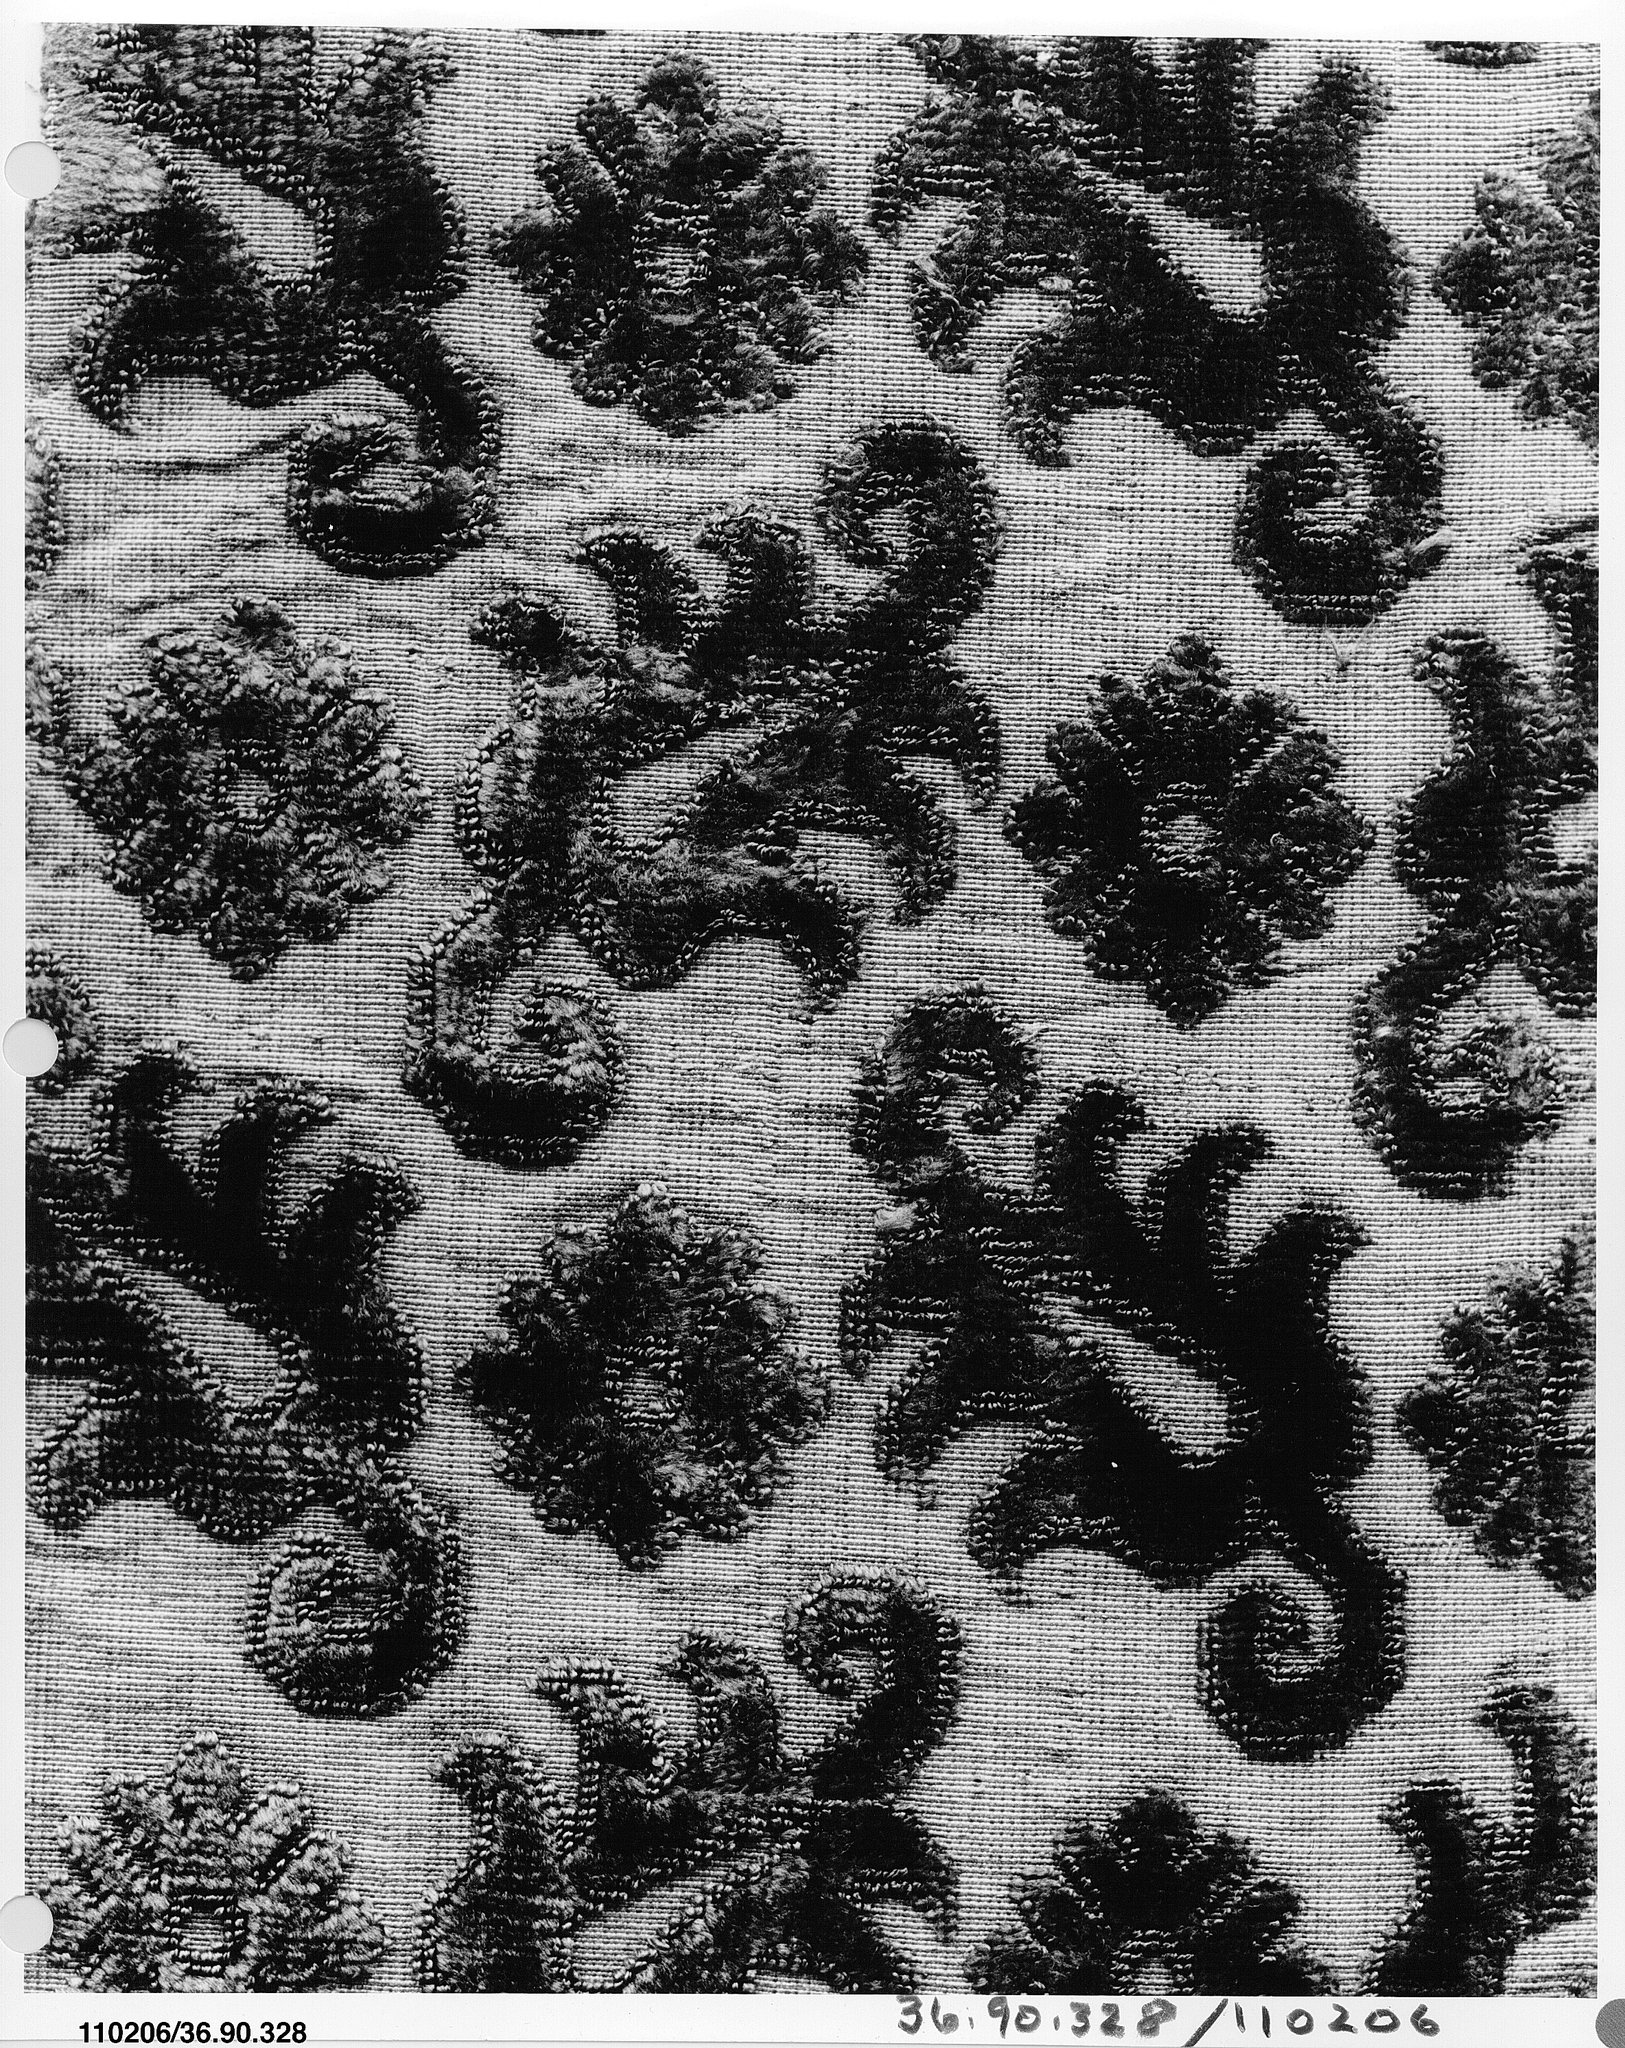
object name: piece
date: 1501-1700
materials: metal thread, silk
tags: flowers,leaves